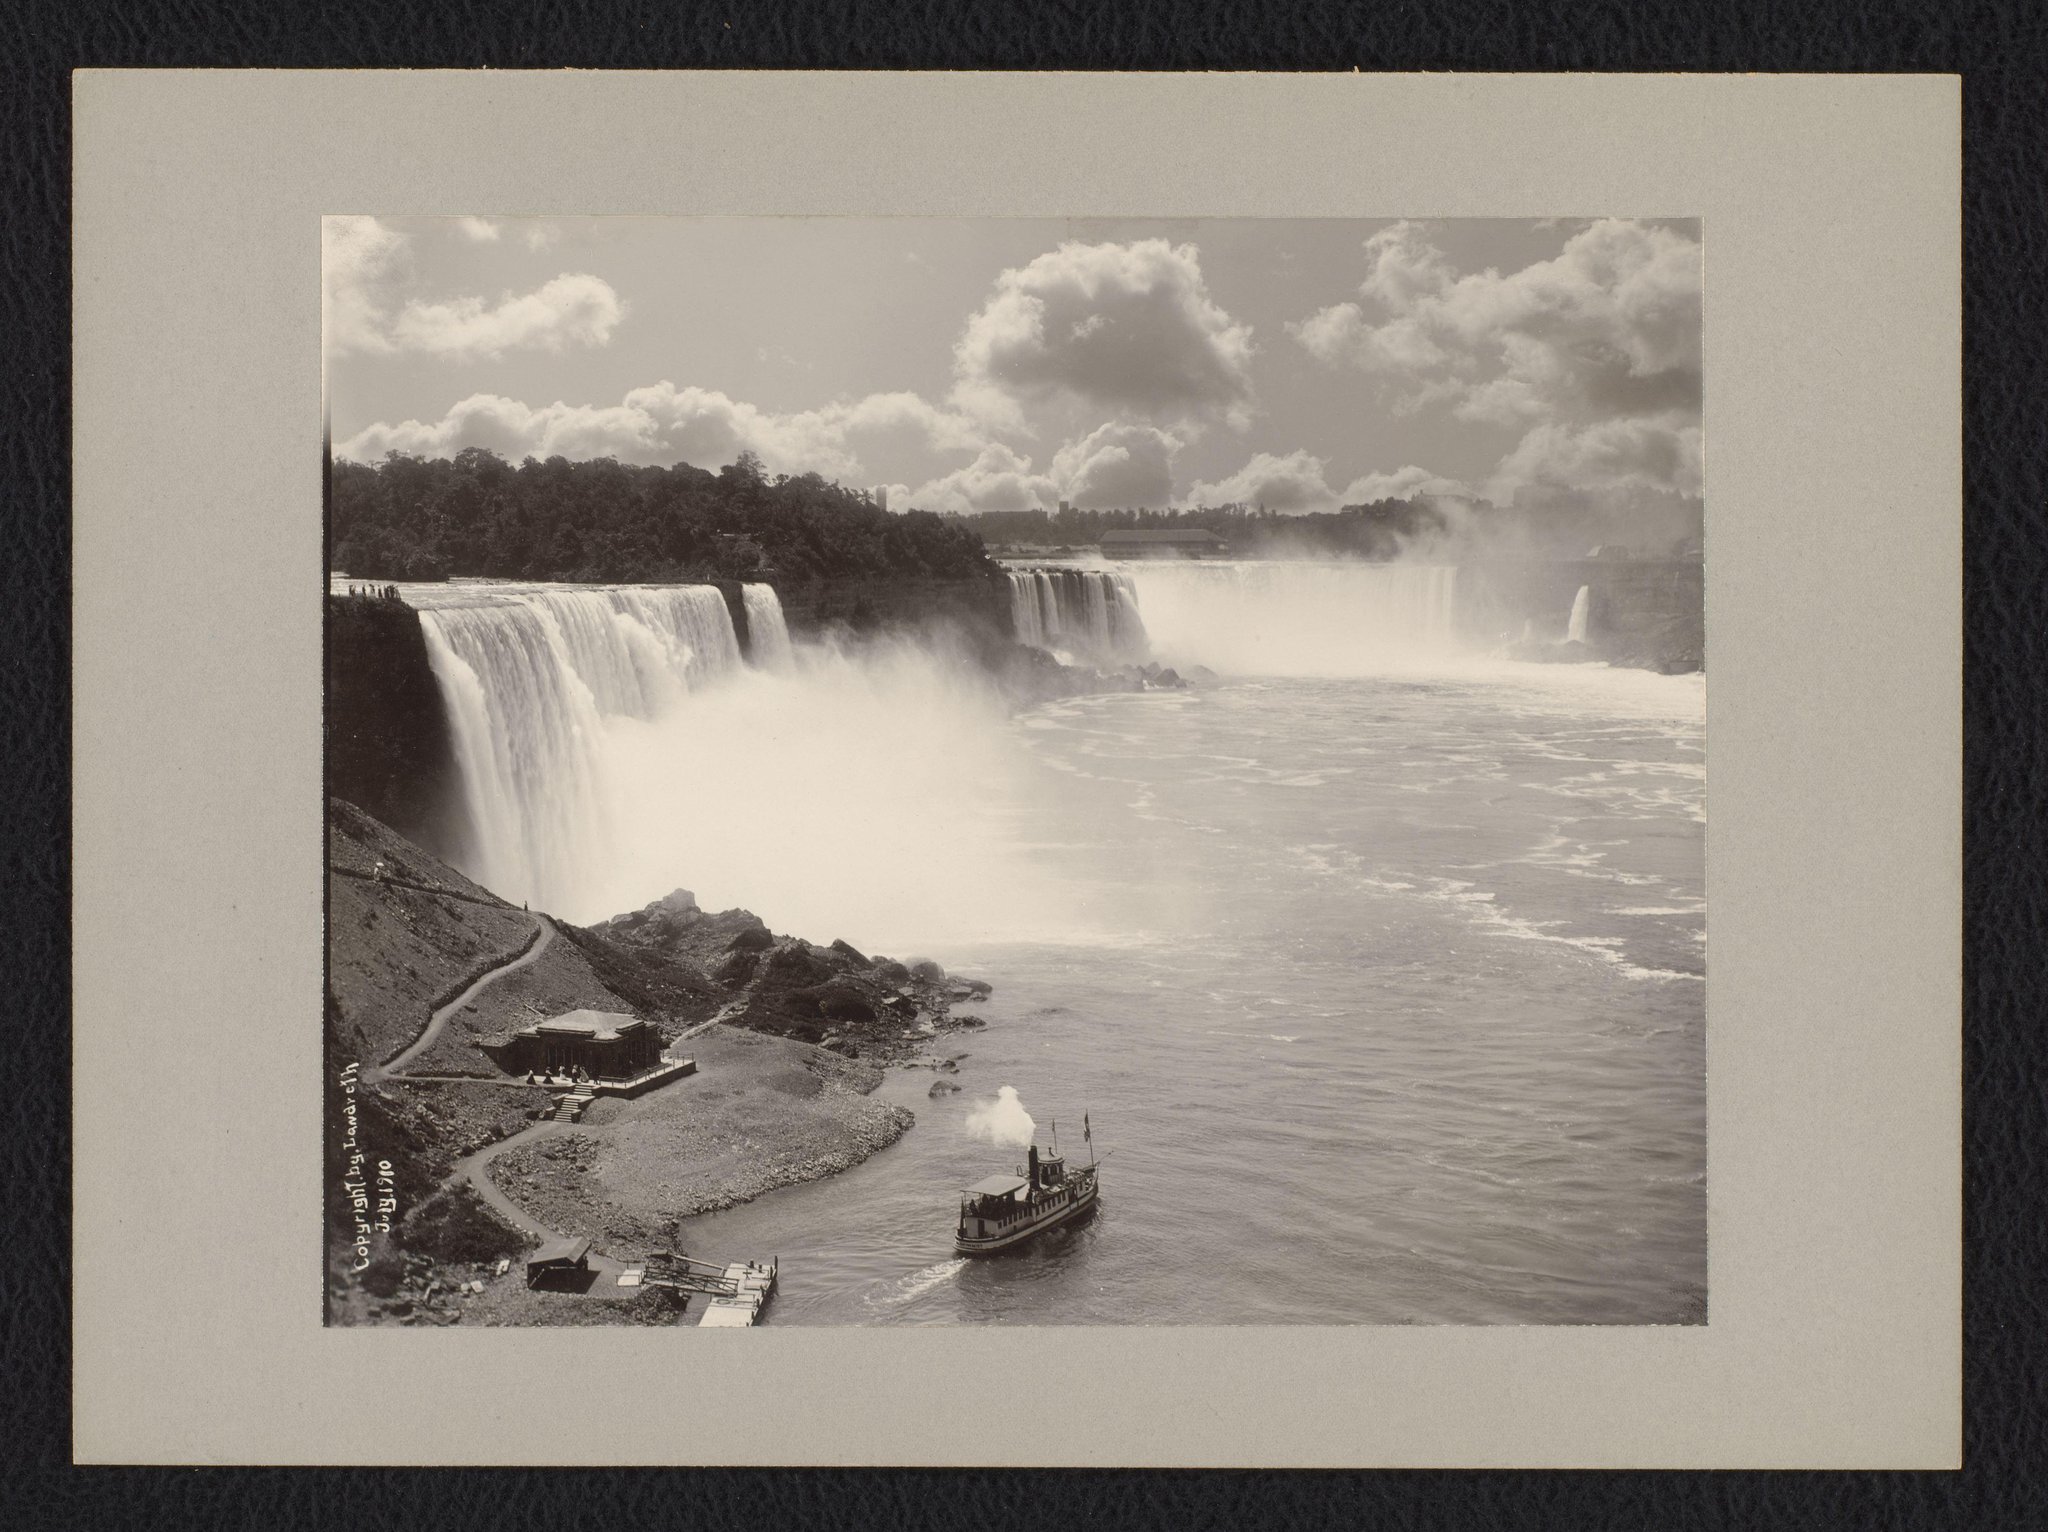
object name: photograph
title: Niagara watervallen, Verenigde Staten/Canada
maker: landreth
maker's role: fotograaf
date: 1910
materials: cardboard, photographic support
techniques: gelatin silver print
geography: niagara falls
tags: niagara falls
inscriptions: annotation: ‘7. Niagara Fall gezien v/d. Canadeeschen kant’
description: Niagara watervallen, midden onder vaart een boot.